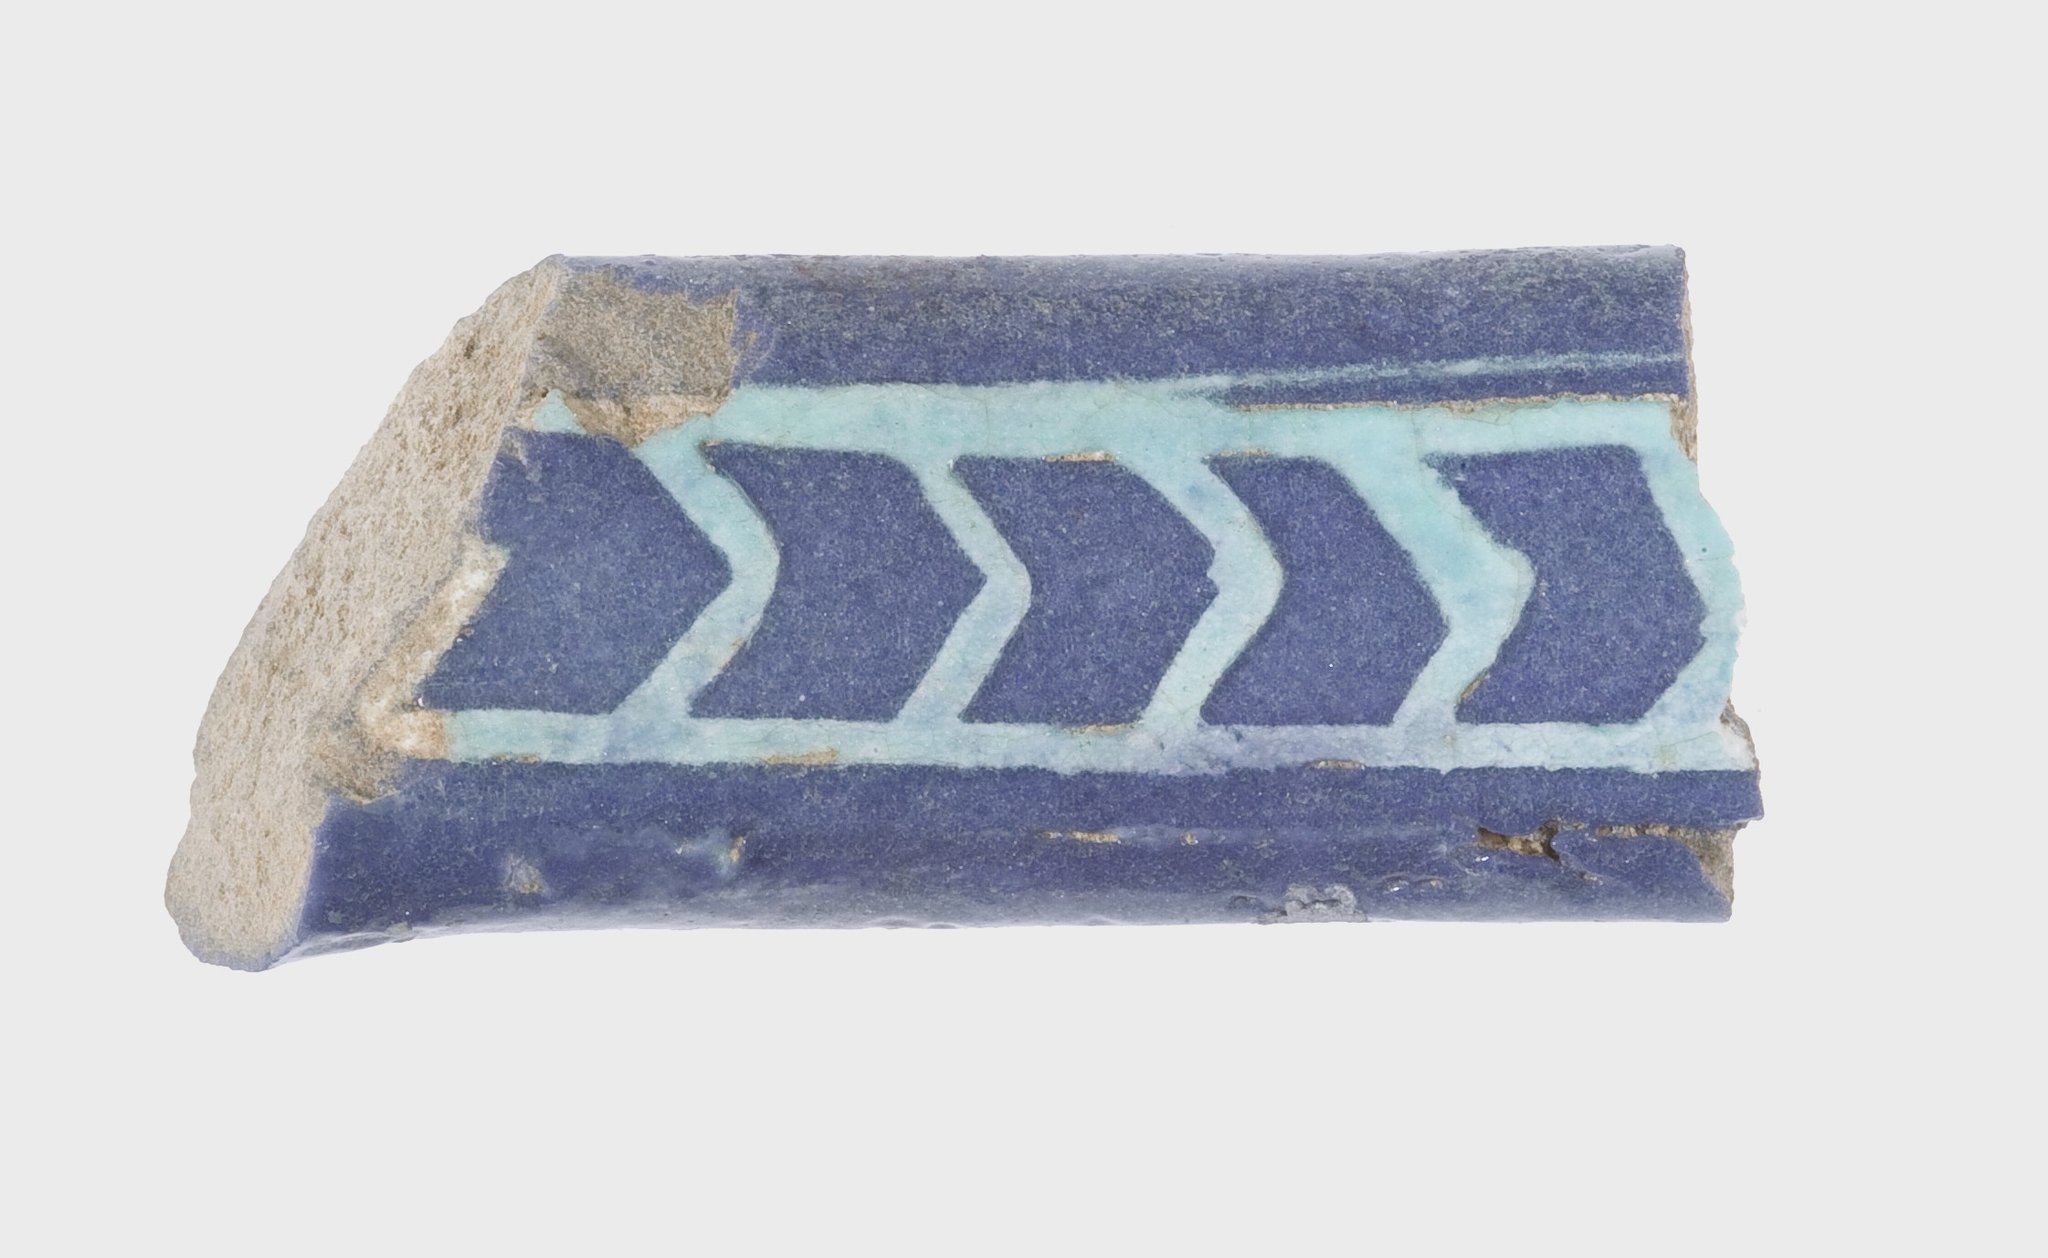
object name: vase, handle fragment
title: Fragment of Vase Handle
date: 1390-1352 BCE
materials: faience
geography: egypt